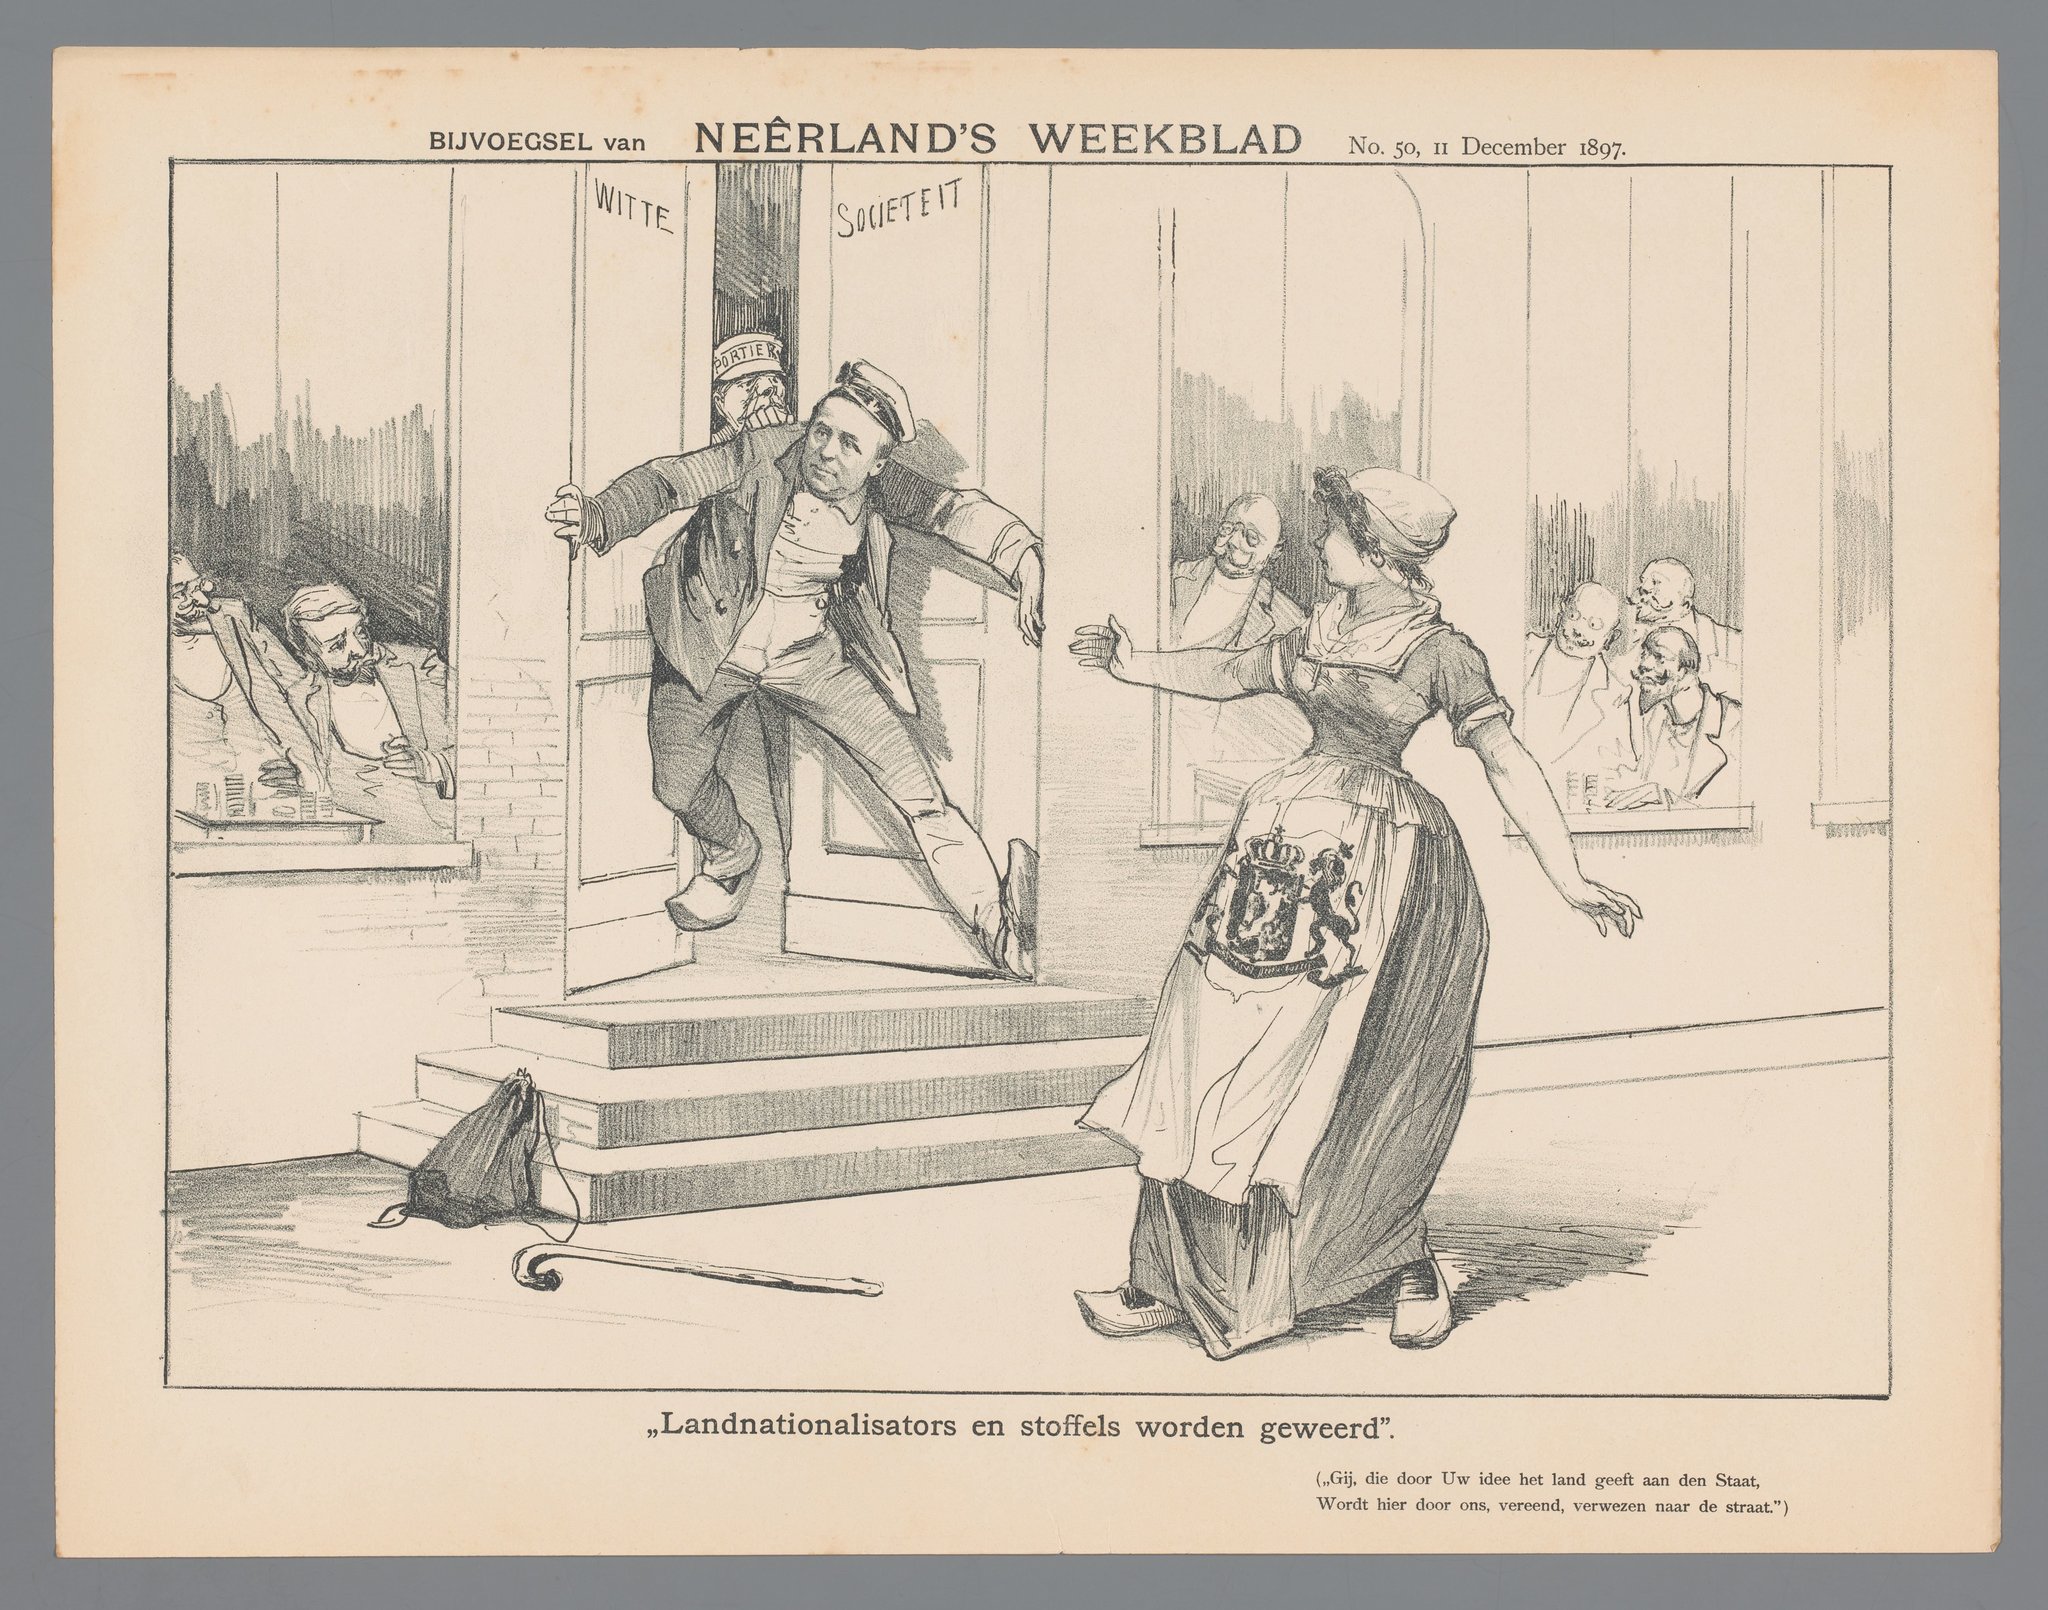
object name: cartoon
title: "Landnationalisators en stoffels worden geweerd"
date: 1897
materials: paper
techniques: lithograph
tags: club, meeting place, personifications of countries, nations, states, districts, etc., political caricatures and satires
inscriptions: date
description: Prent uit het bijvoegsel van: Neêrland’s Weekblad, nr. 50, 11 december 1897.